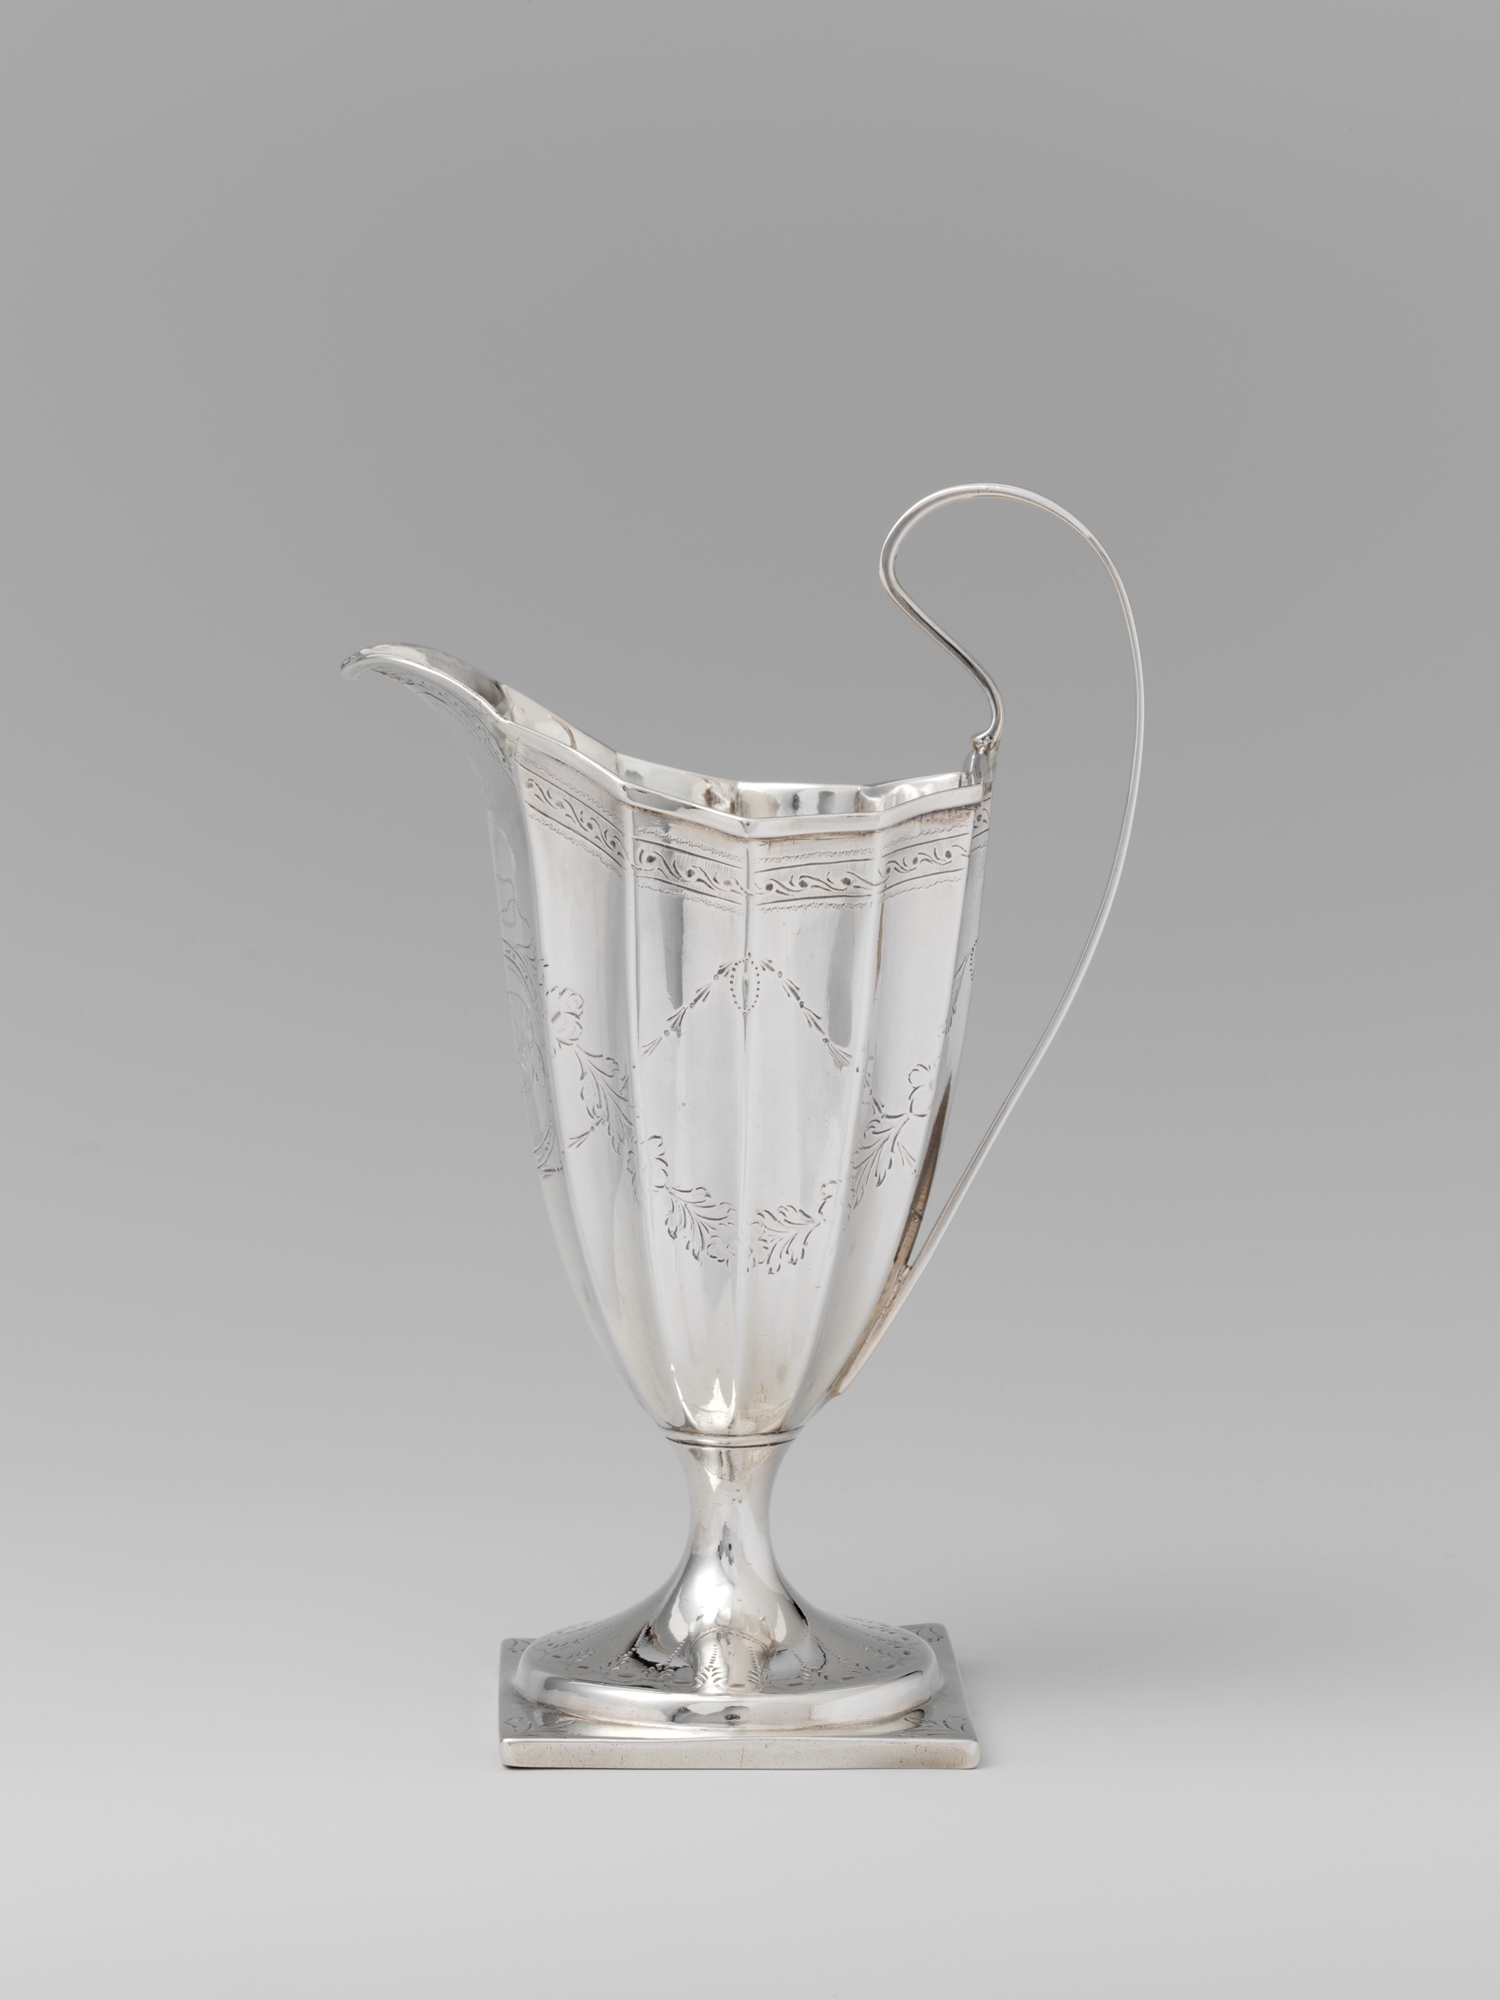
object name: cream pot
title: Creampot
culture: american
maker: paul revere jr.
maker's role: maker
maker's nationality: american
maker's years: 1734-1818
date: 1790-1795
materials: silver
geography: united states